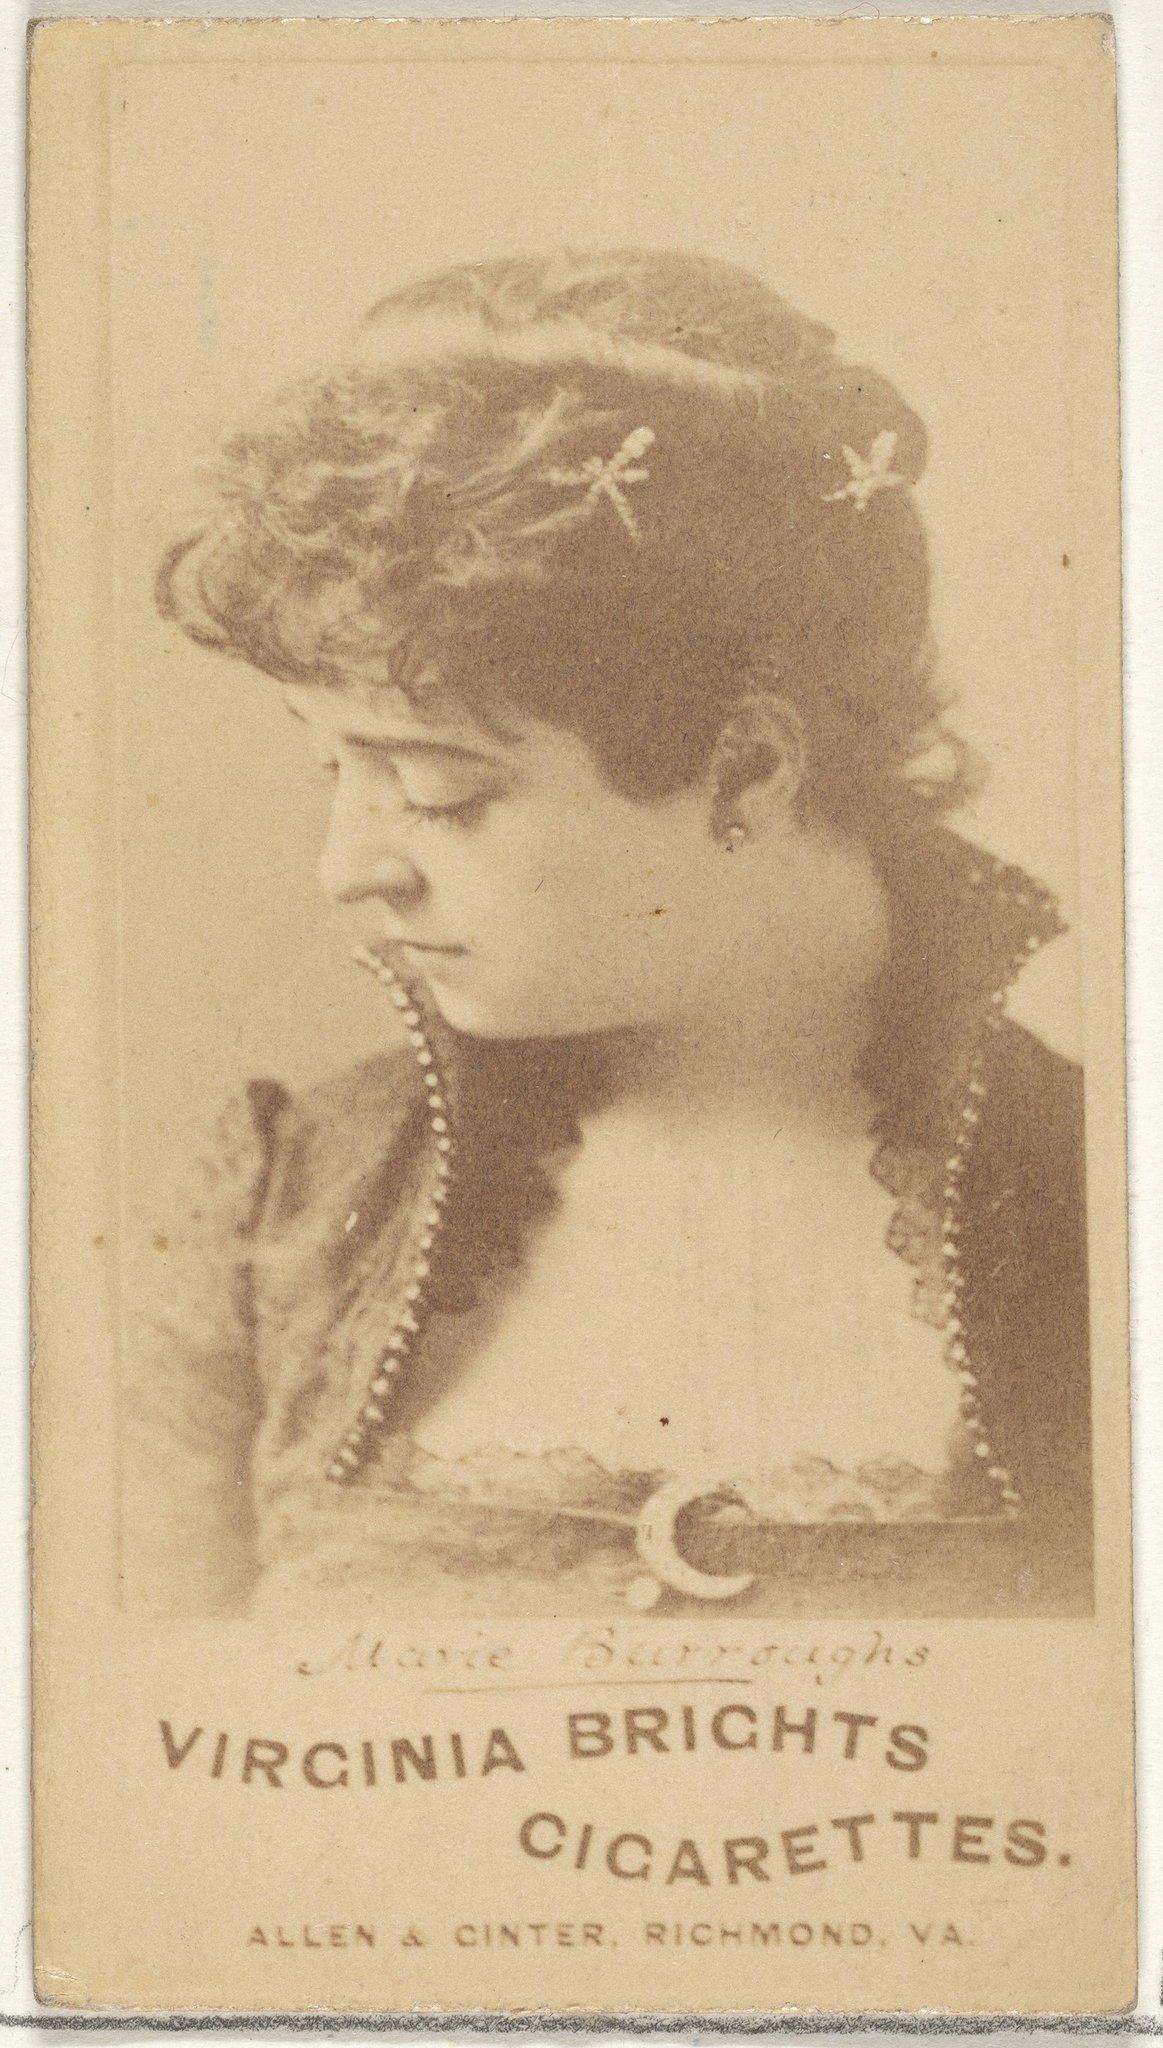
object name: photograph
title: Marie Burroughs, from the Actors and Actresses series (N45, Type 1) for Virginia Brights Cigarettes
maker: allen & ginter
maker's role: publisher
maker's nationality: american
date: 1888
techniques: albumen silver print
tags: portraits,women,actresses